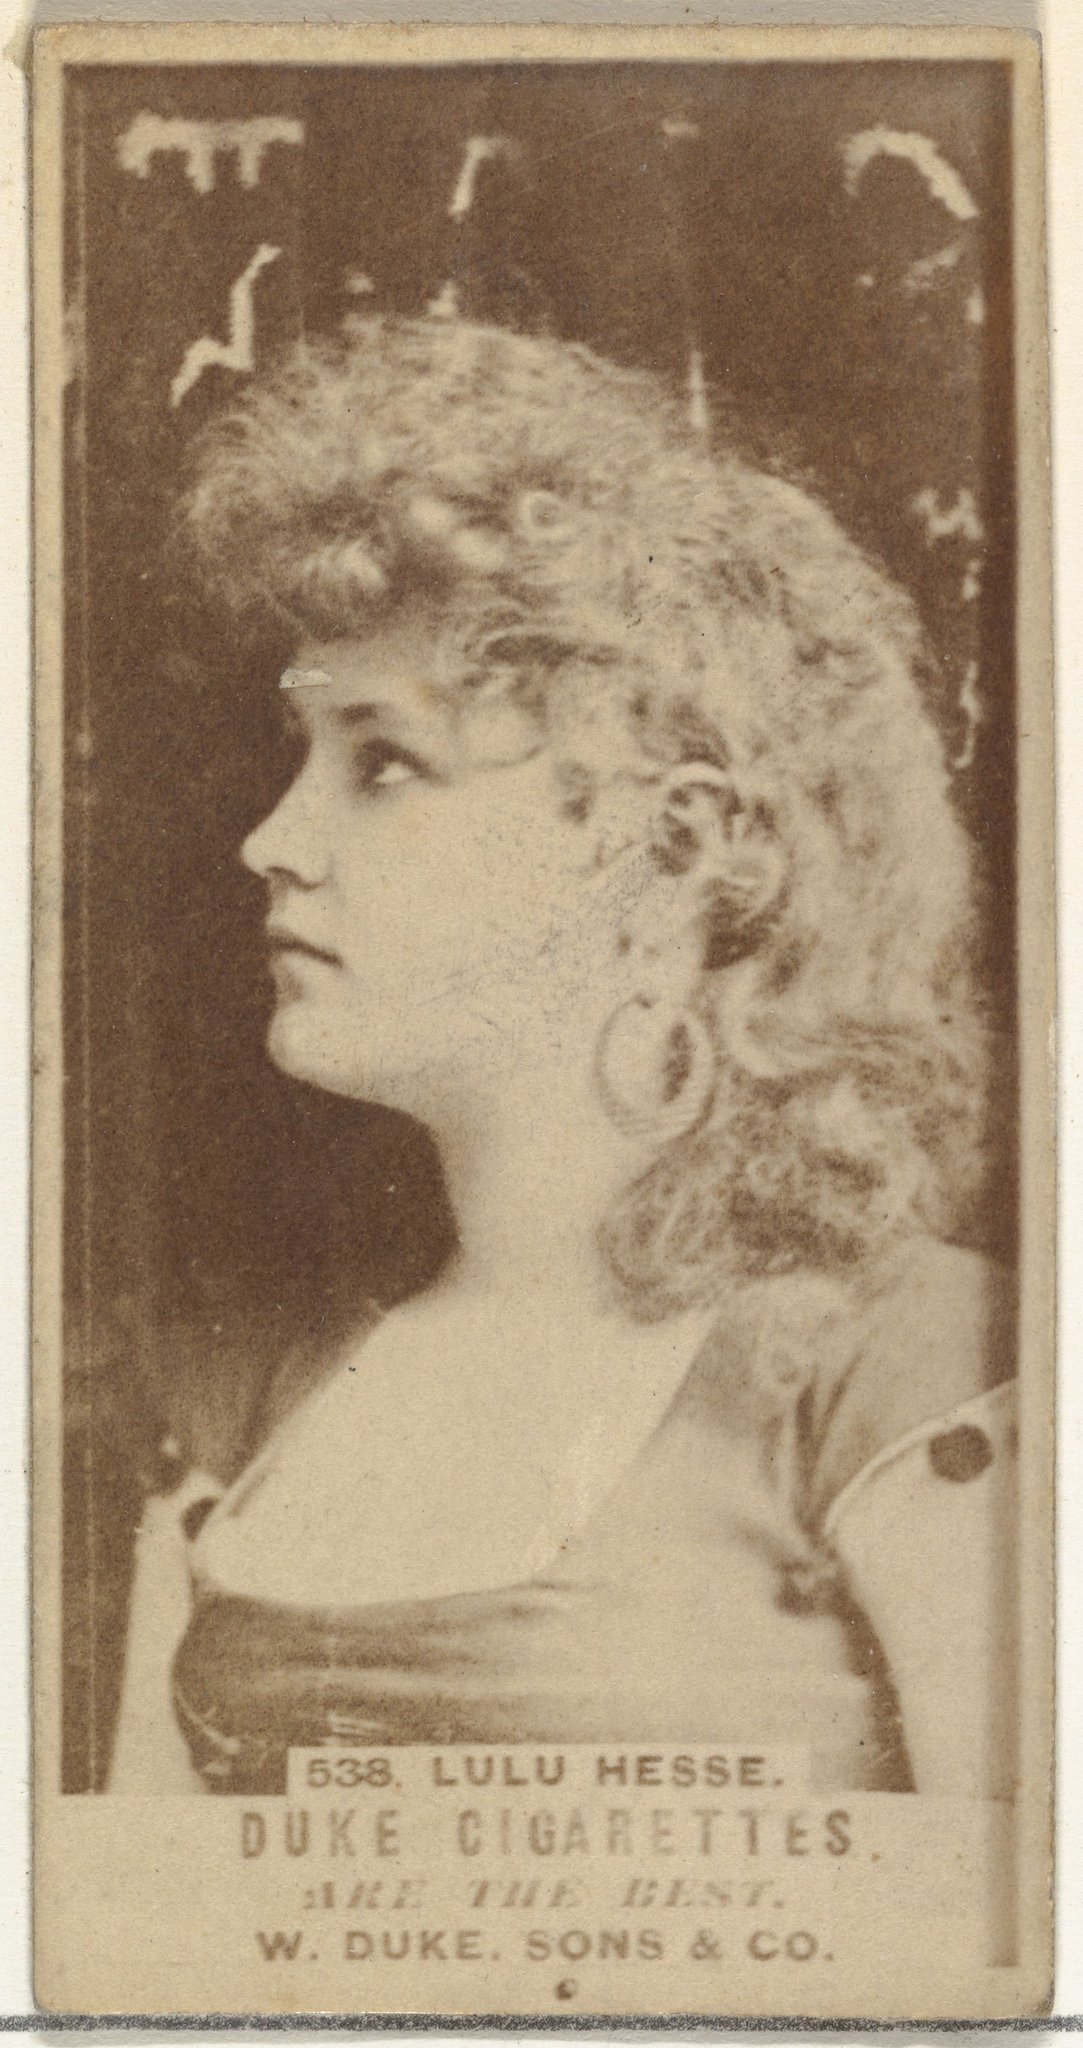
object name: photograph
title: Card Number 538, Lulu Hesse, from the Actors and Actresses series (N145-7) issued by Duke Sons & Co. to promote Duke Cigarettes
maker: w. duke, sons & co.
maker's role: publisher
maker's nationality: american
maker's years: 1870-1920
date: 1880-1889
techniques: albumen silver print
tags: women,actresses